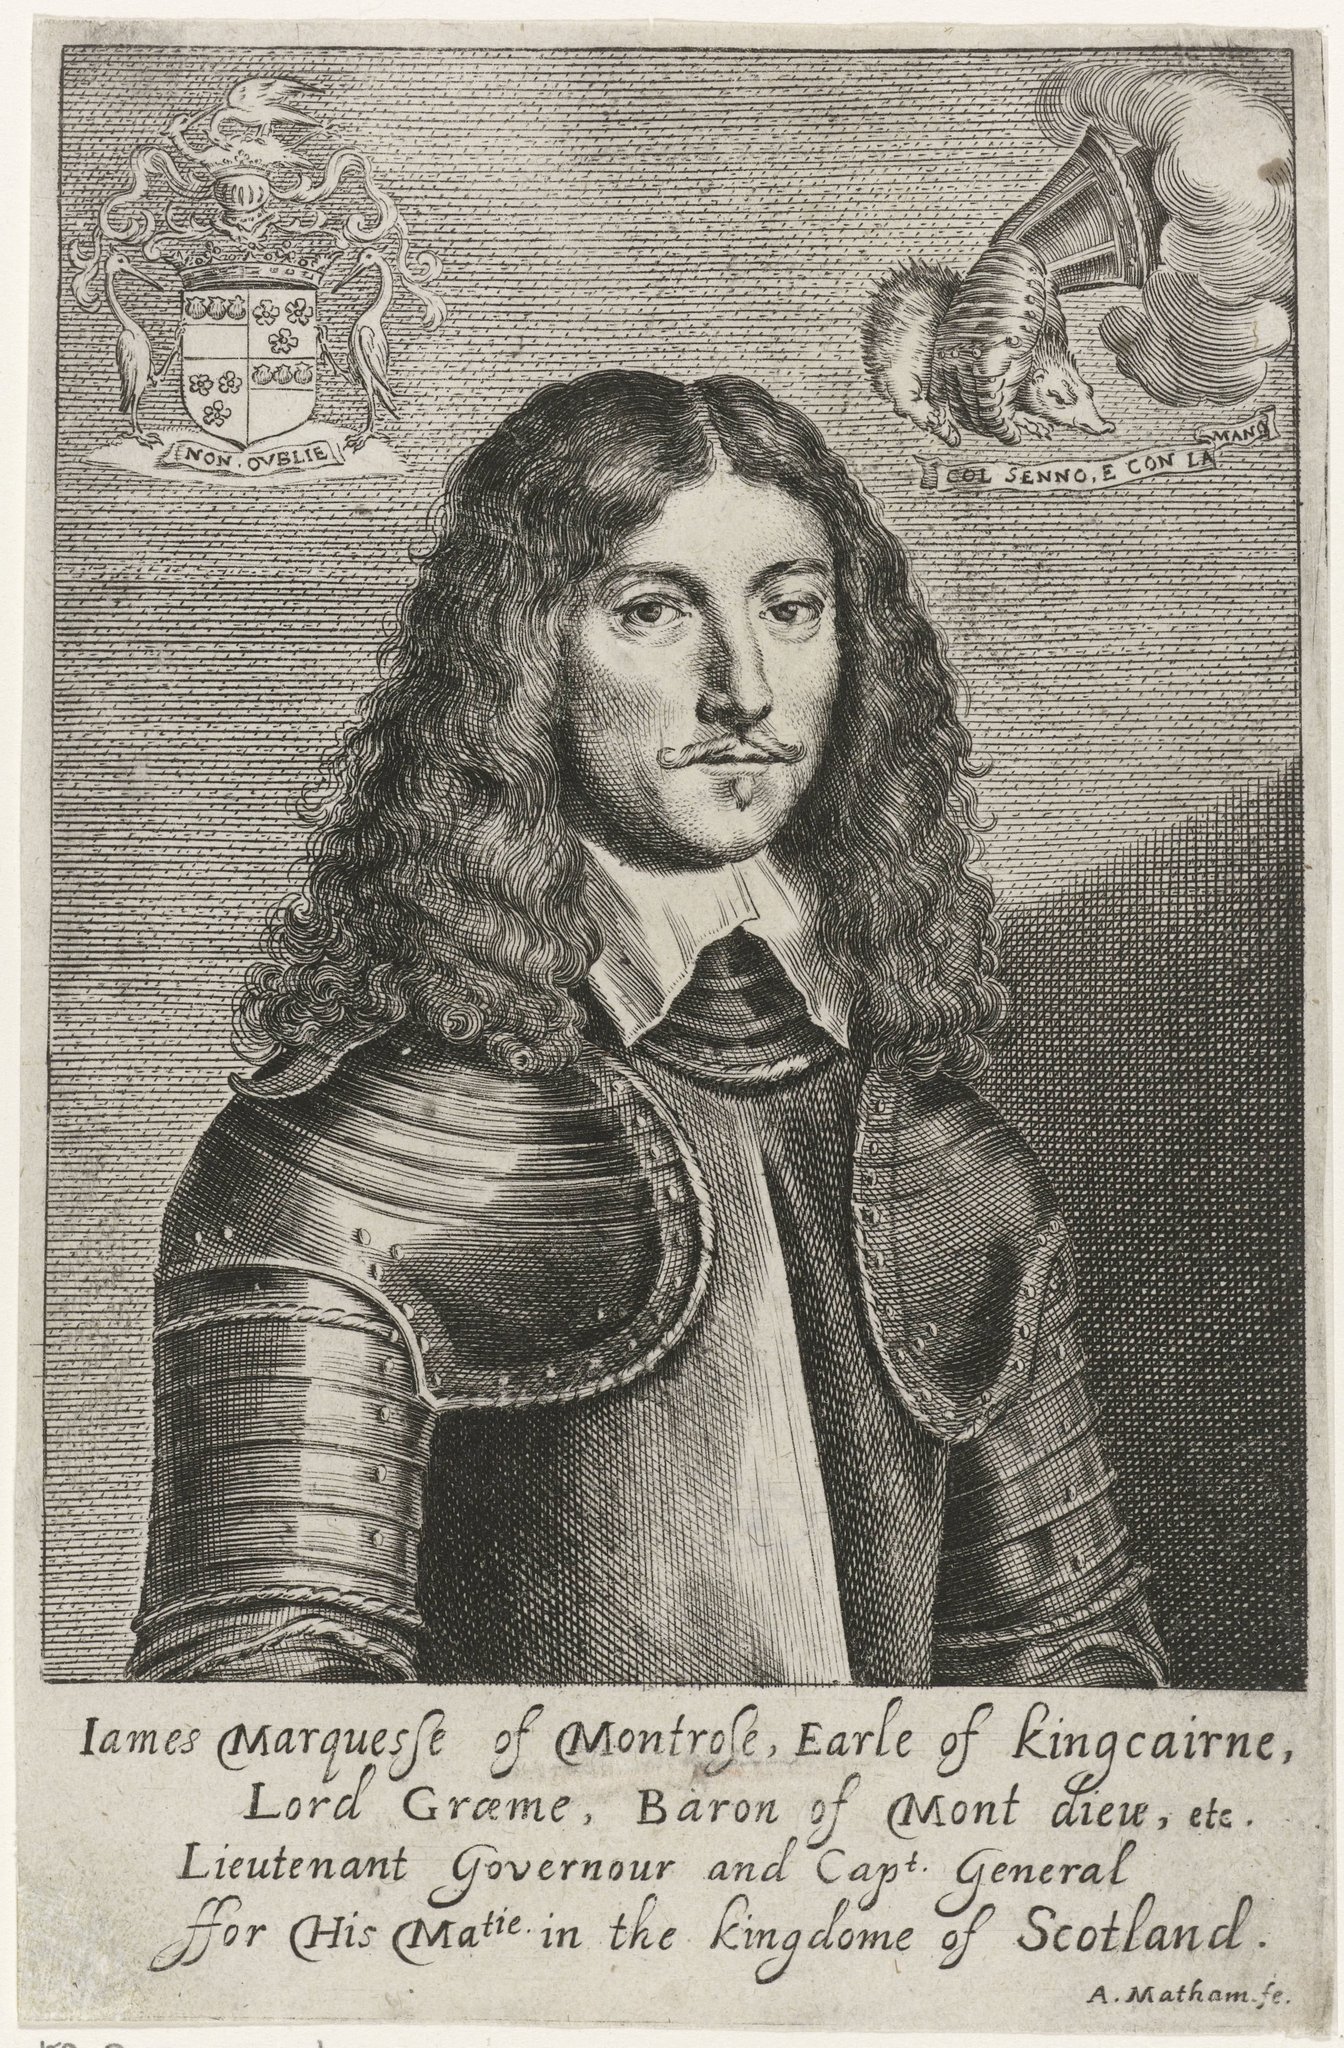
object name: print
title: Portret van James Graham, markies van Monrose, graaf van Kingcairne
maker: adriaen matham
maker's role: draughtsman, print maker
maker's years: 1599-1660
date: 1620-1660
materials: paper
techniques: engraving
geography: northern netherlands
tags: james graham (1e markies van montrose)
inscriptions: collector's mark: Lugt 2228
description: Portret van James Graham, eerste markies van Montrose en graaf van Kingcairne.